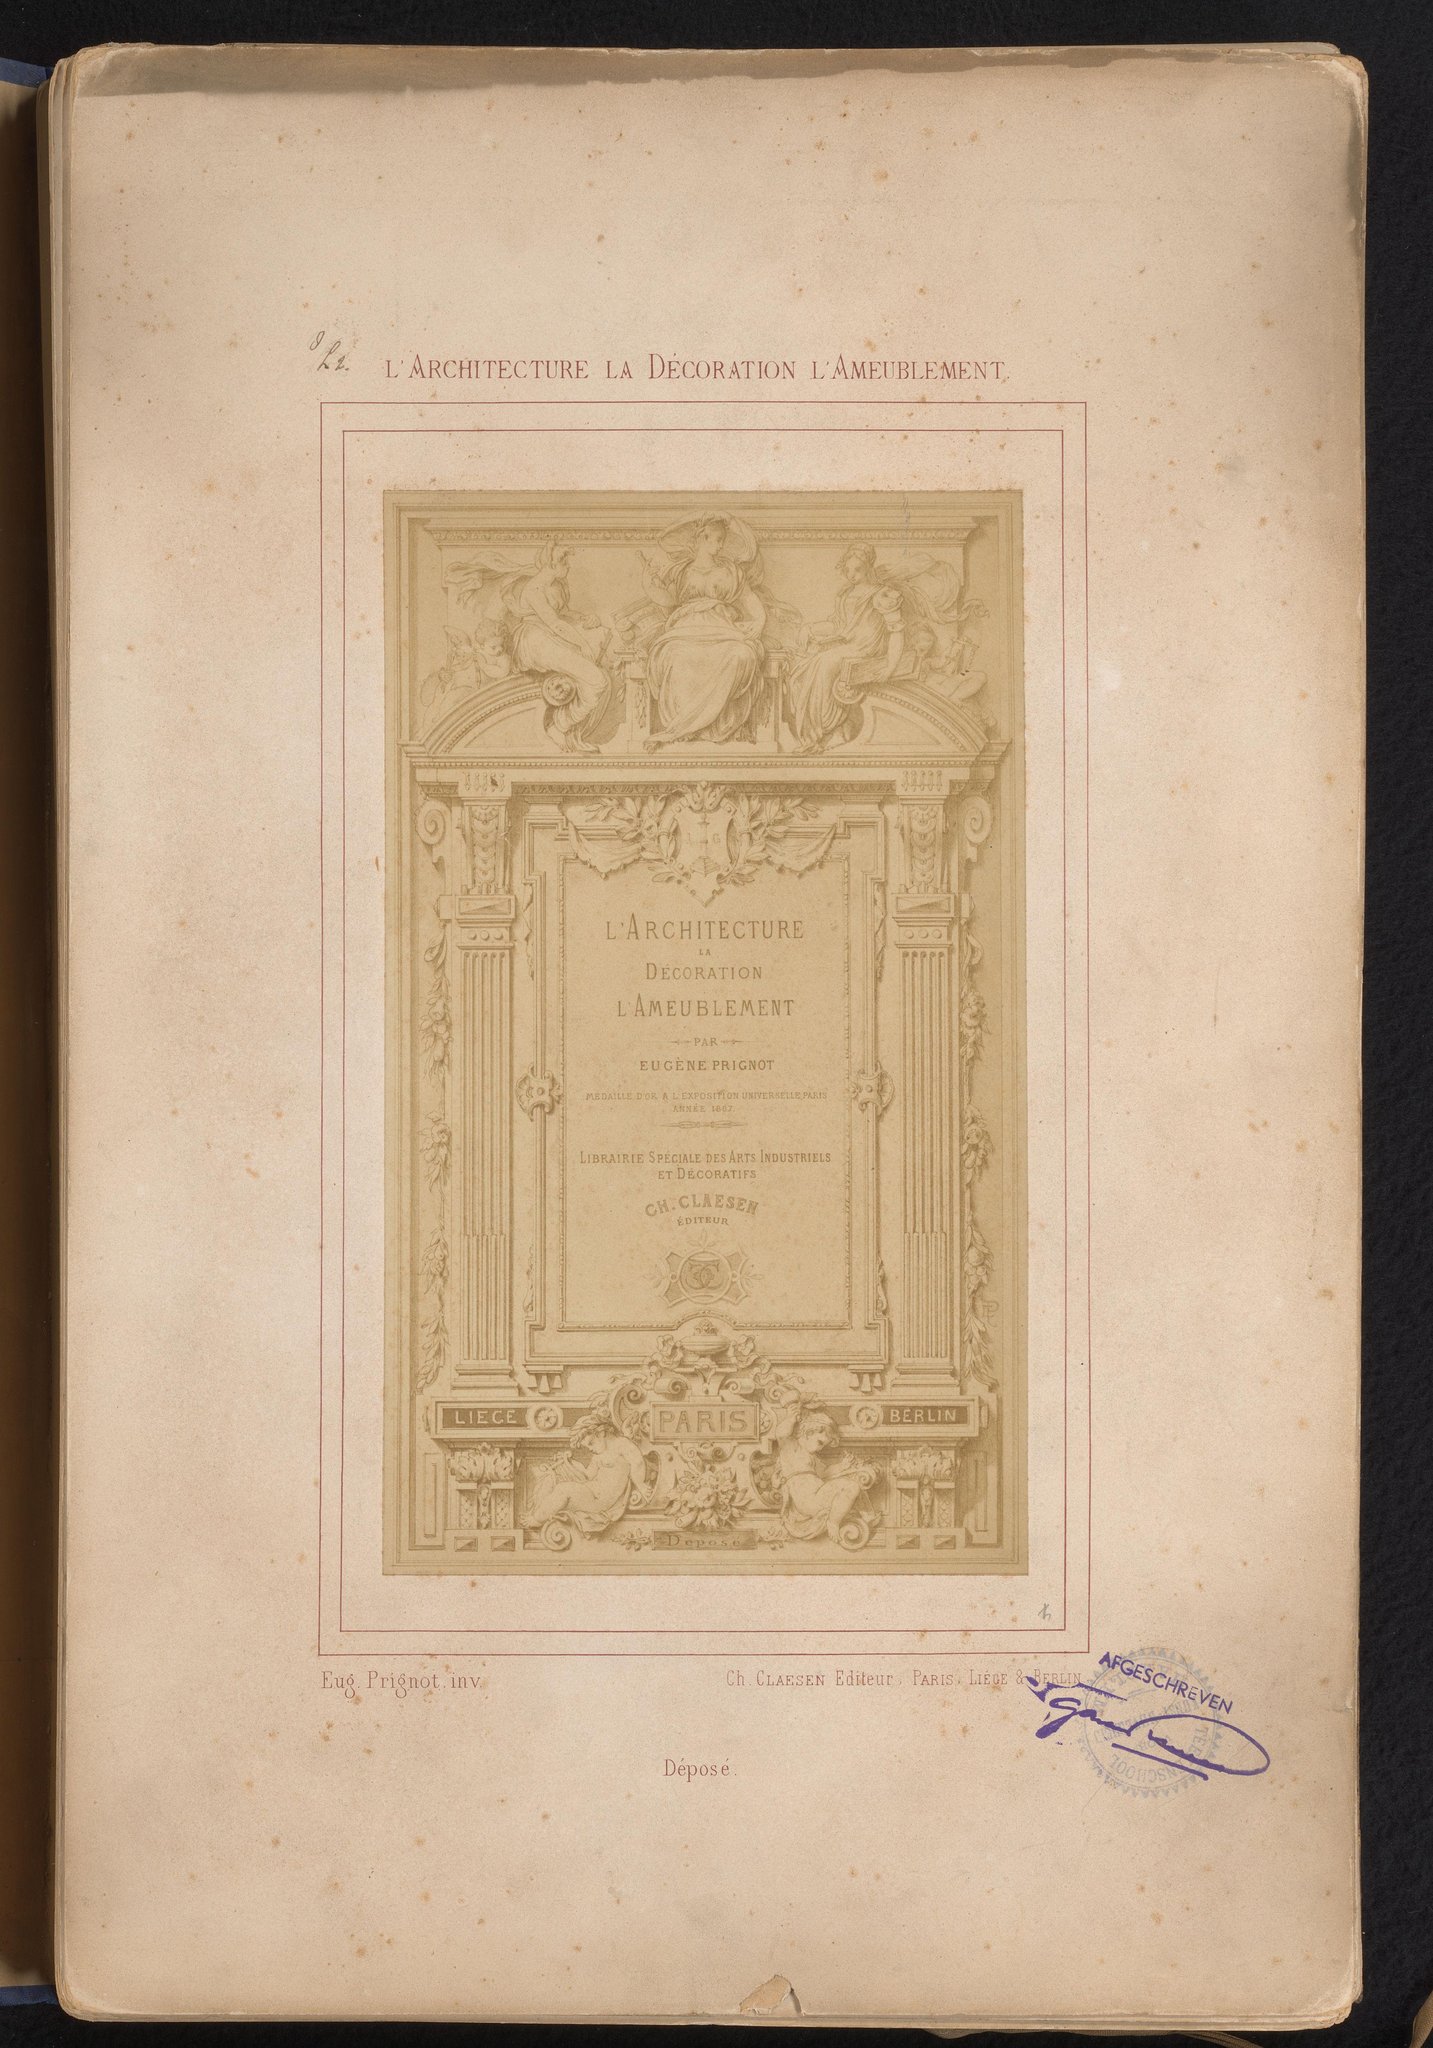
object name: photograph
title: L'Architecture, la Décoration l'Ameublement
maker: Anonymous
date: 1873-1880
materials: cardboard, paper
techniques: albumen print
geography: liège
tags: title-page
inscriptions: inscription: ‘Déposé’, inscription: ‘Eug. Prignot. inv.’, stamp: ‘AFGESCHREVEN/ [...]’, stamp: ‘TEEKENSCHOOL/ VOOR/ KUNSTNIJVERHEID/ HAARLEM’, inscription: ‘8/ L2’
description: Deze foto maakt deel uit van een omslag met 61 foto's op 61 bladen.